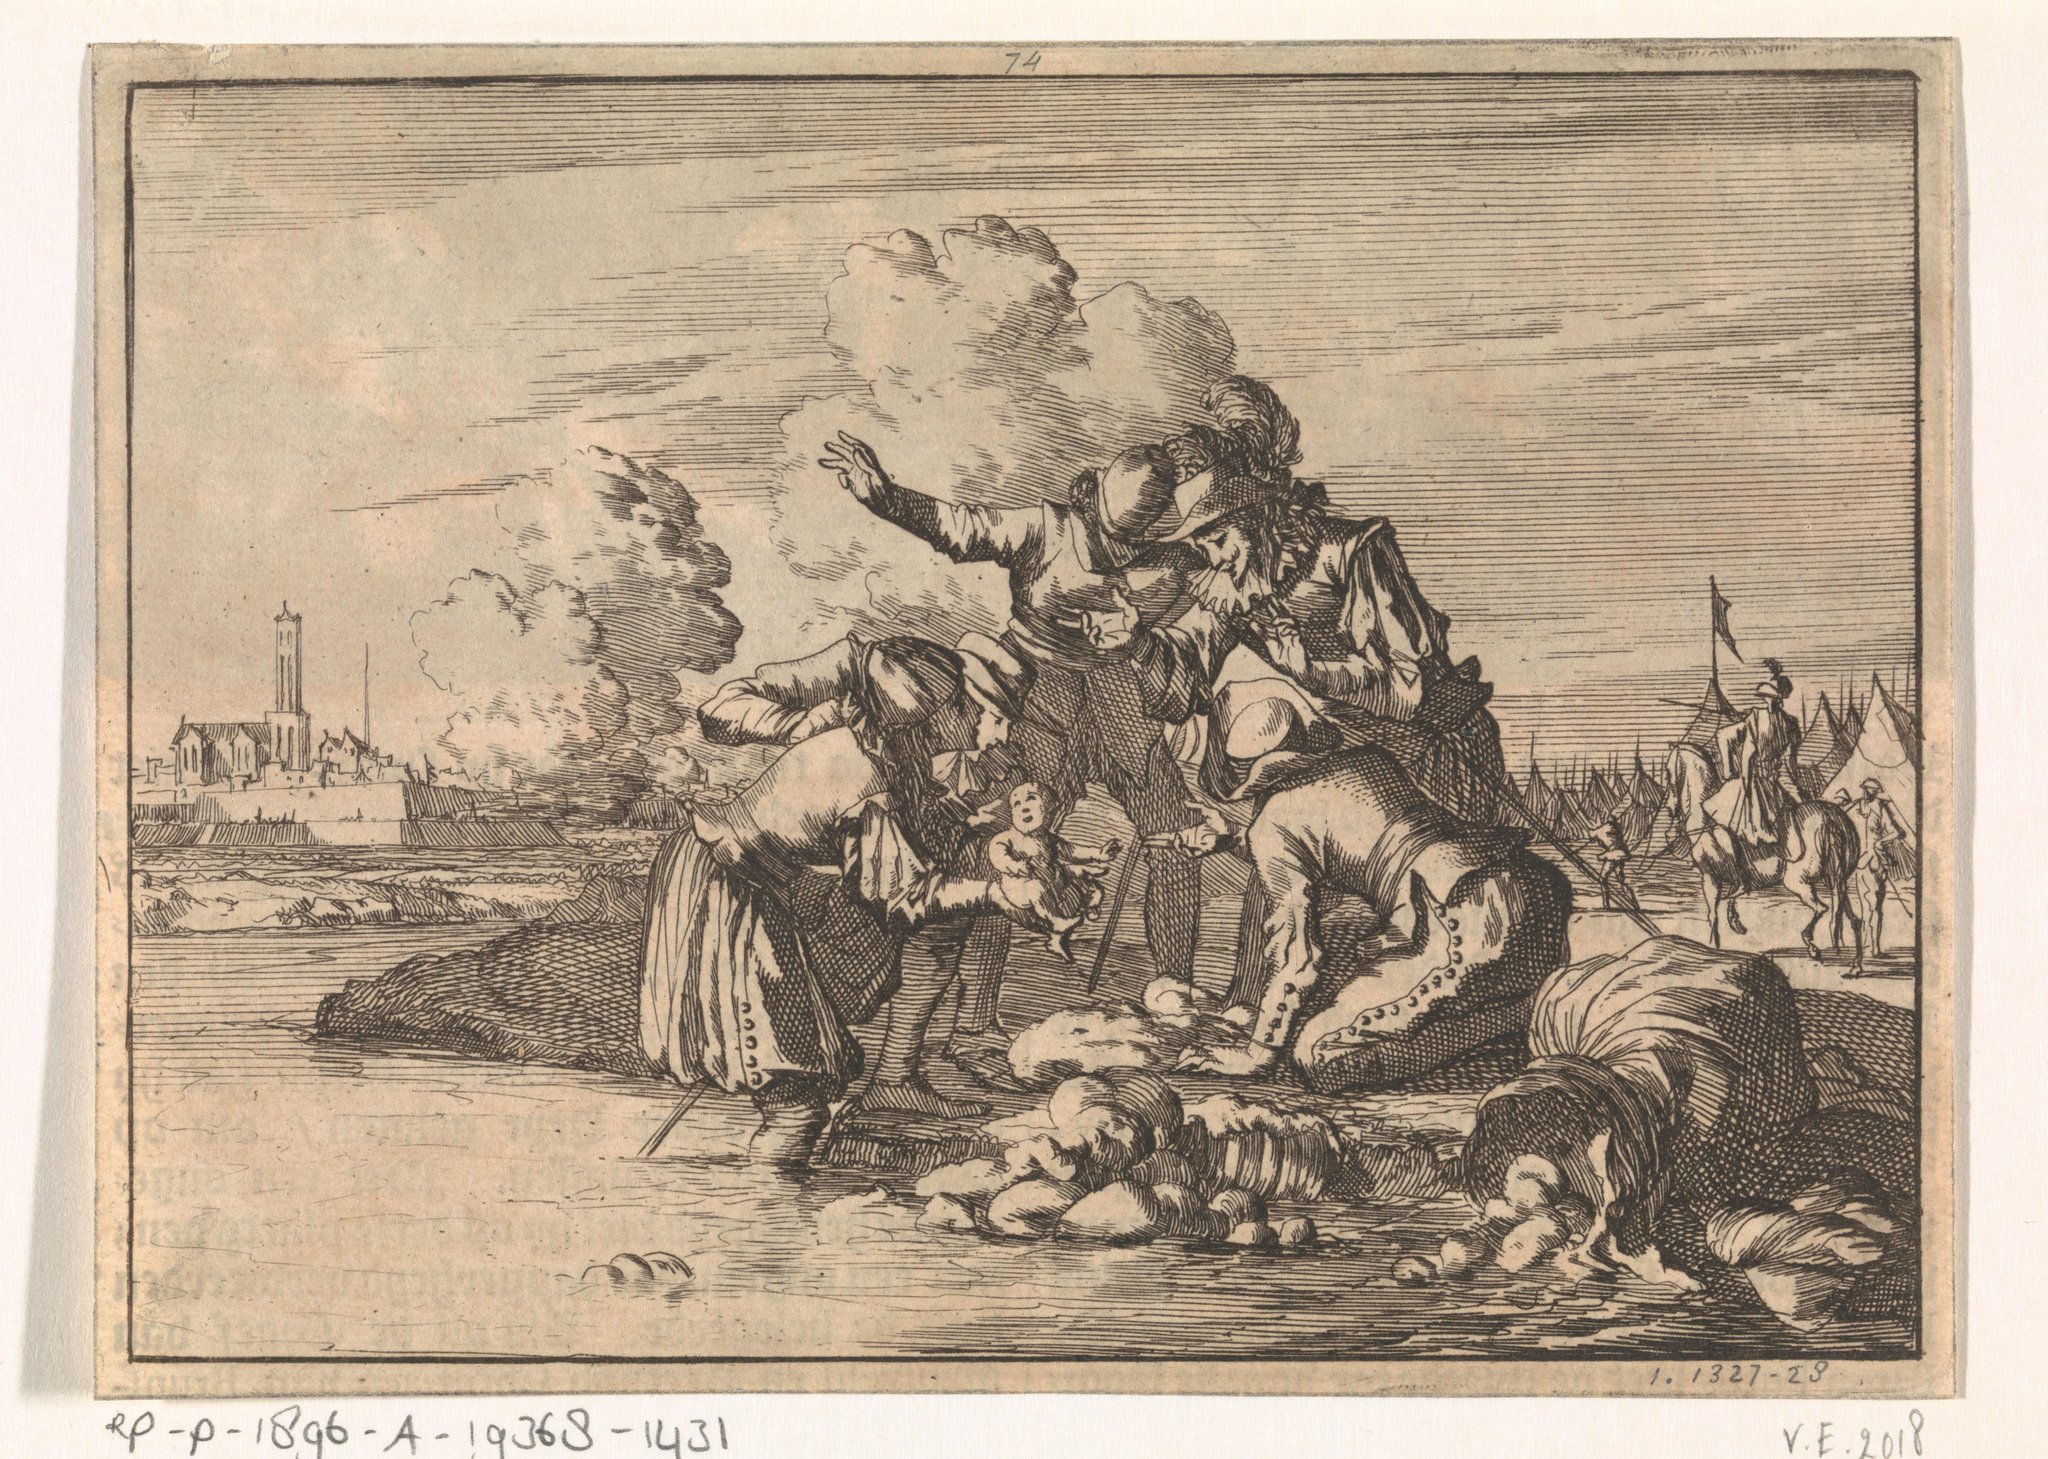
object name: book illustration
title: In het belegerde Bergen op Zoom werd een Spaanse soldatenvrouw door een kanonskogel gedood, haar kind werd echter levend geboren, 1622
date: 1698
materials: paper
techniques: etching, letterpress printing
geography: amsterdam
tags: violent death by firearms, confinement, birth, bergen op zoom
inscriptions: collector's mark: Lugt 2228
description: Illustratie uit: Gottfried, Johann Ludwig. Historische kronyck; vervattende een (...) beschrijvingh der aldergedenckwaerdigste geschiedenissen des weerelds, van den aenvangh der scheppingh tot (...) 1576 (2 delen). Leiden: Pieter van der Aa, 1698, dl. I, p. 1327.